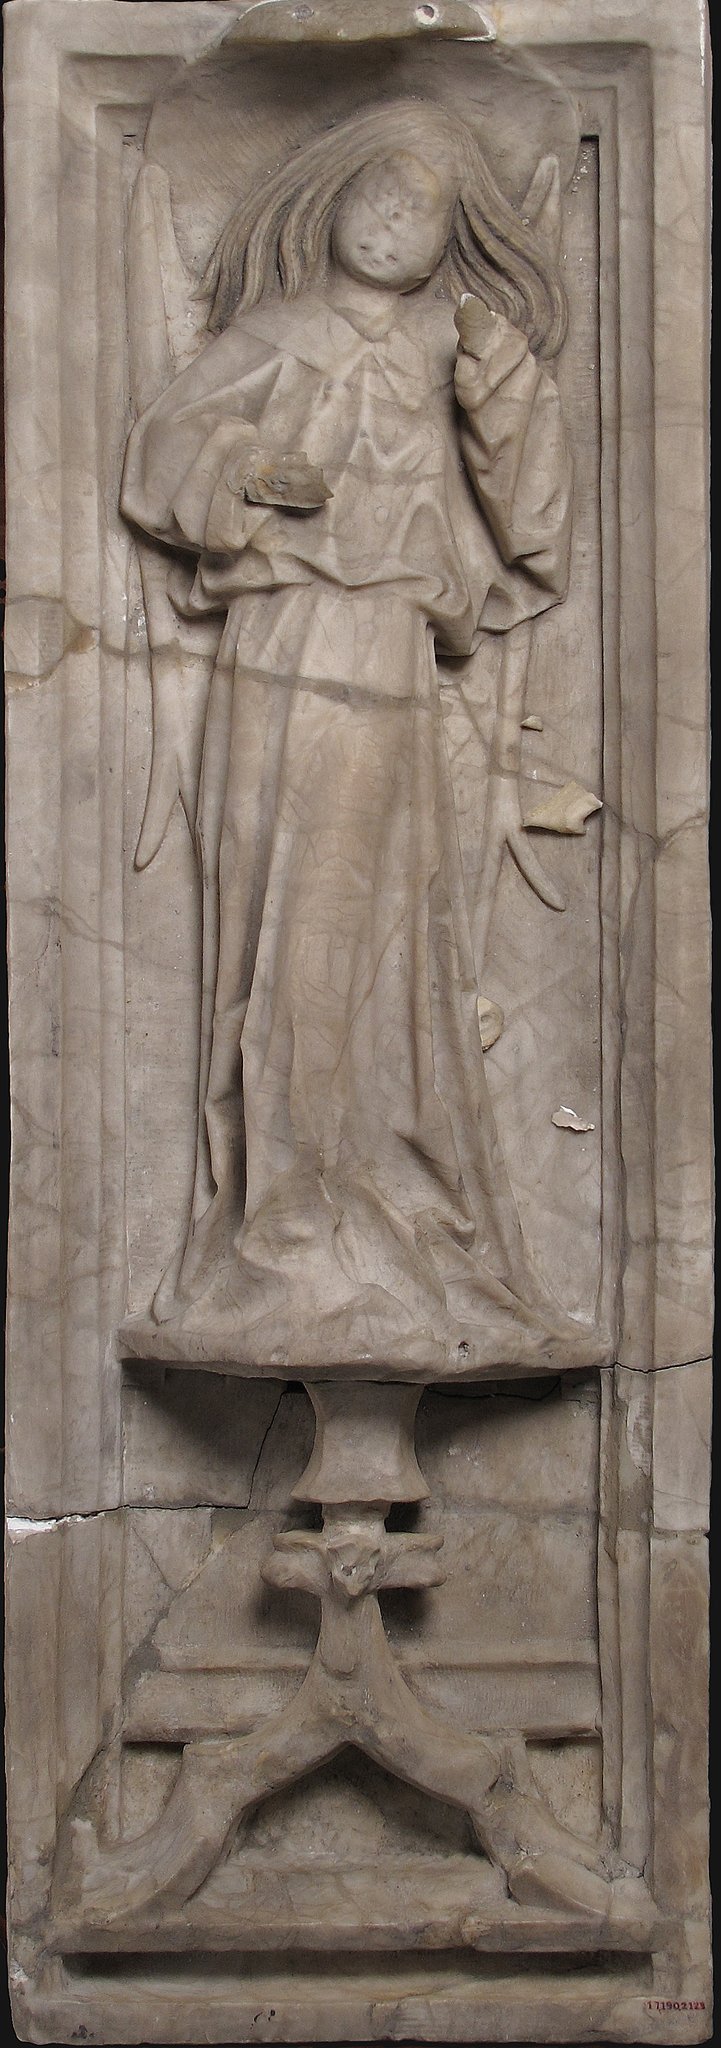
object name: panel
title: Panel from the Tomb of Don Garcia Osorio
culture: spanish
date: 1501-1600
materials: alabaster